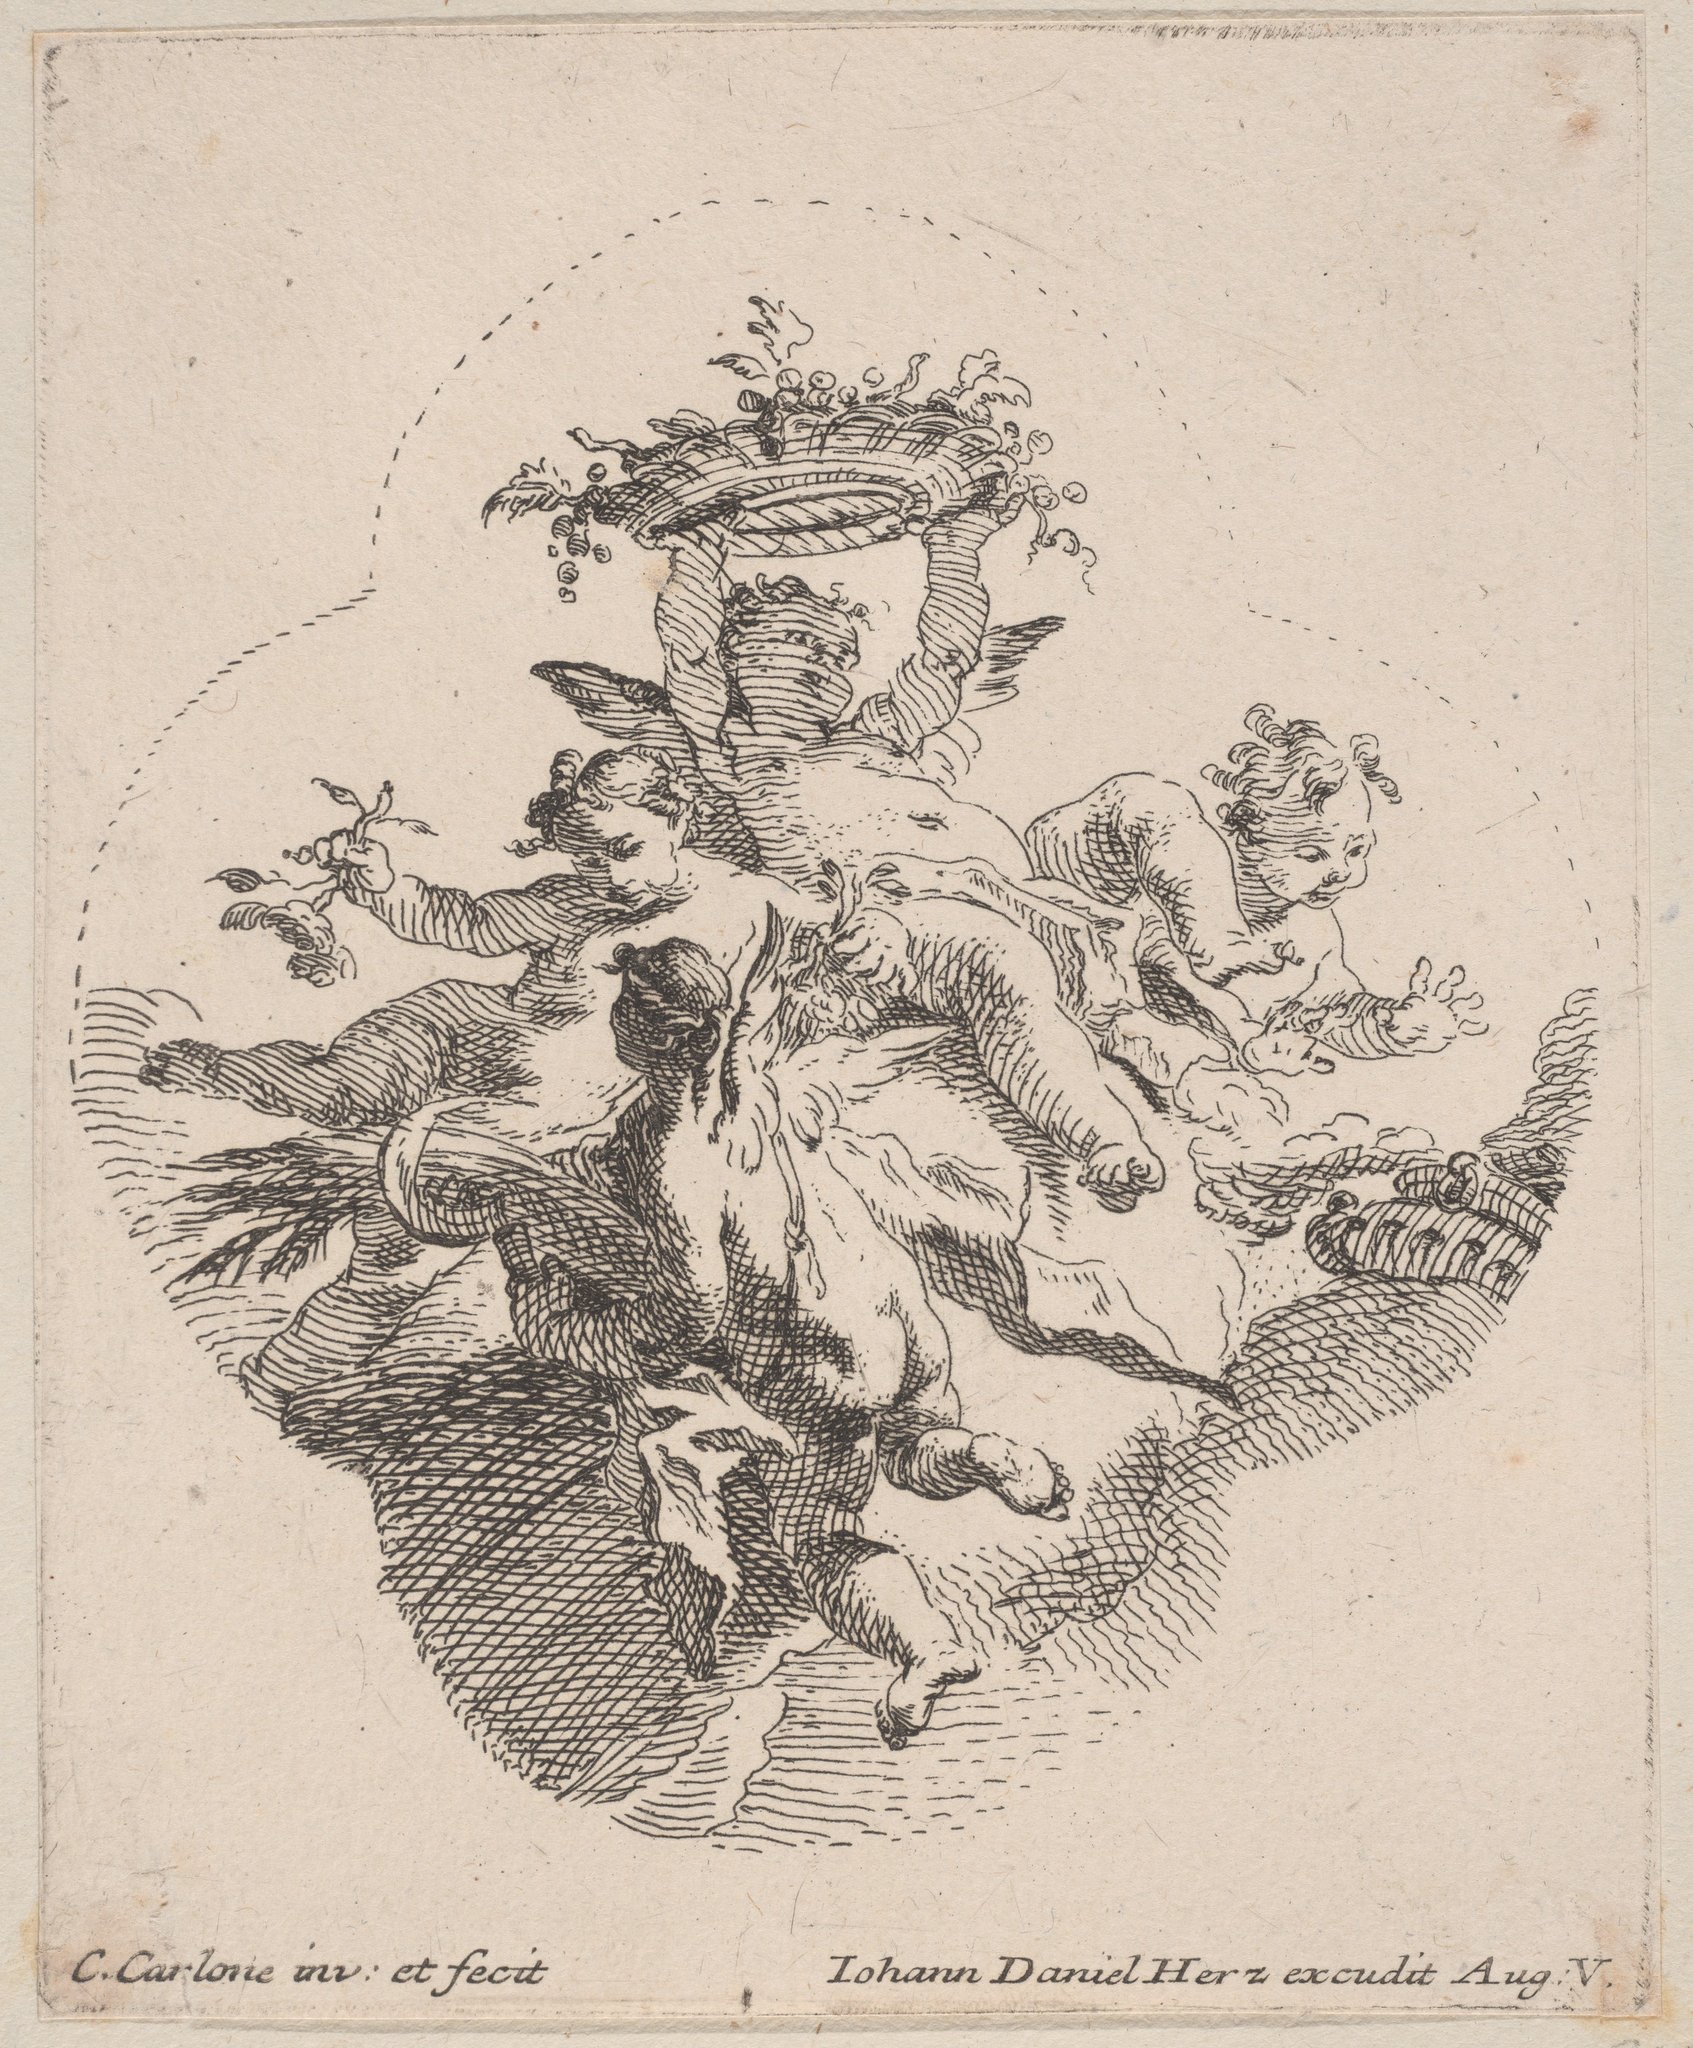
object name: print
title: Putti holding flowers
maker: carlo innocenzo carloni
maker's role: artist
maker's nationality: italian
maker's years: 1686-1775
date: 1725-1775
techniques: etching